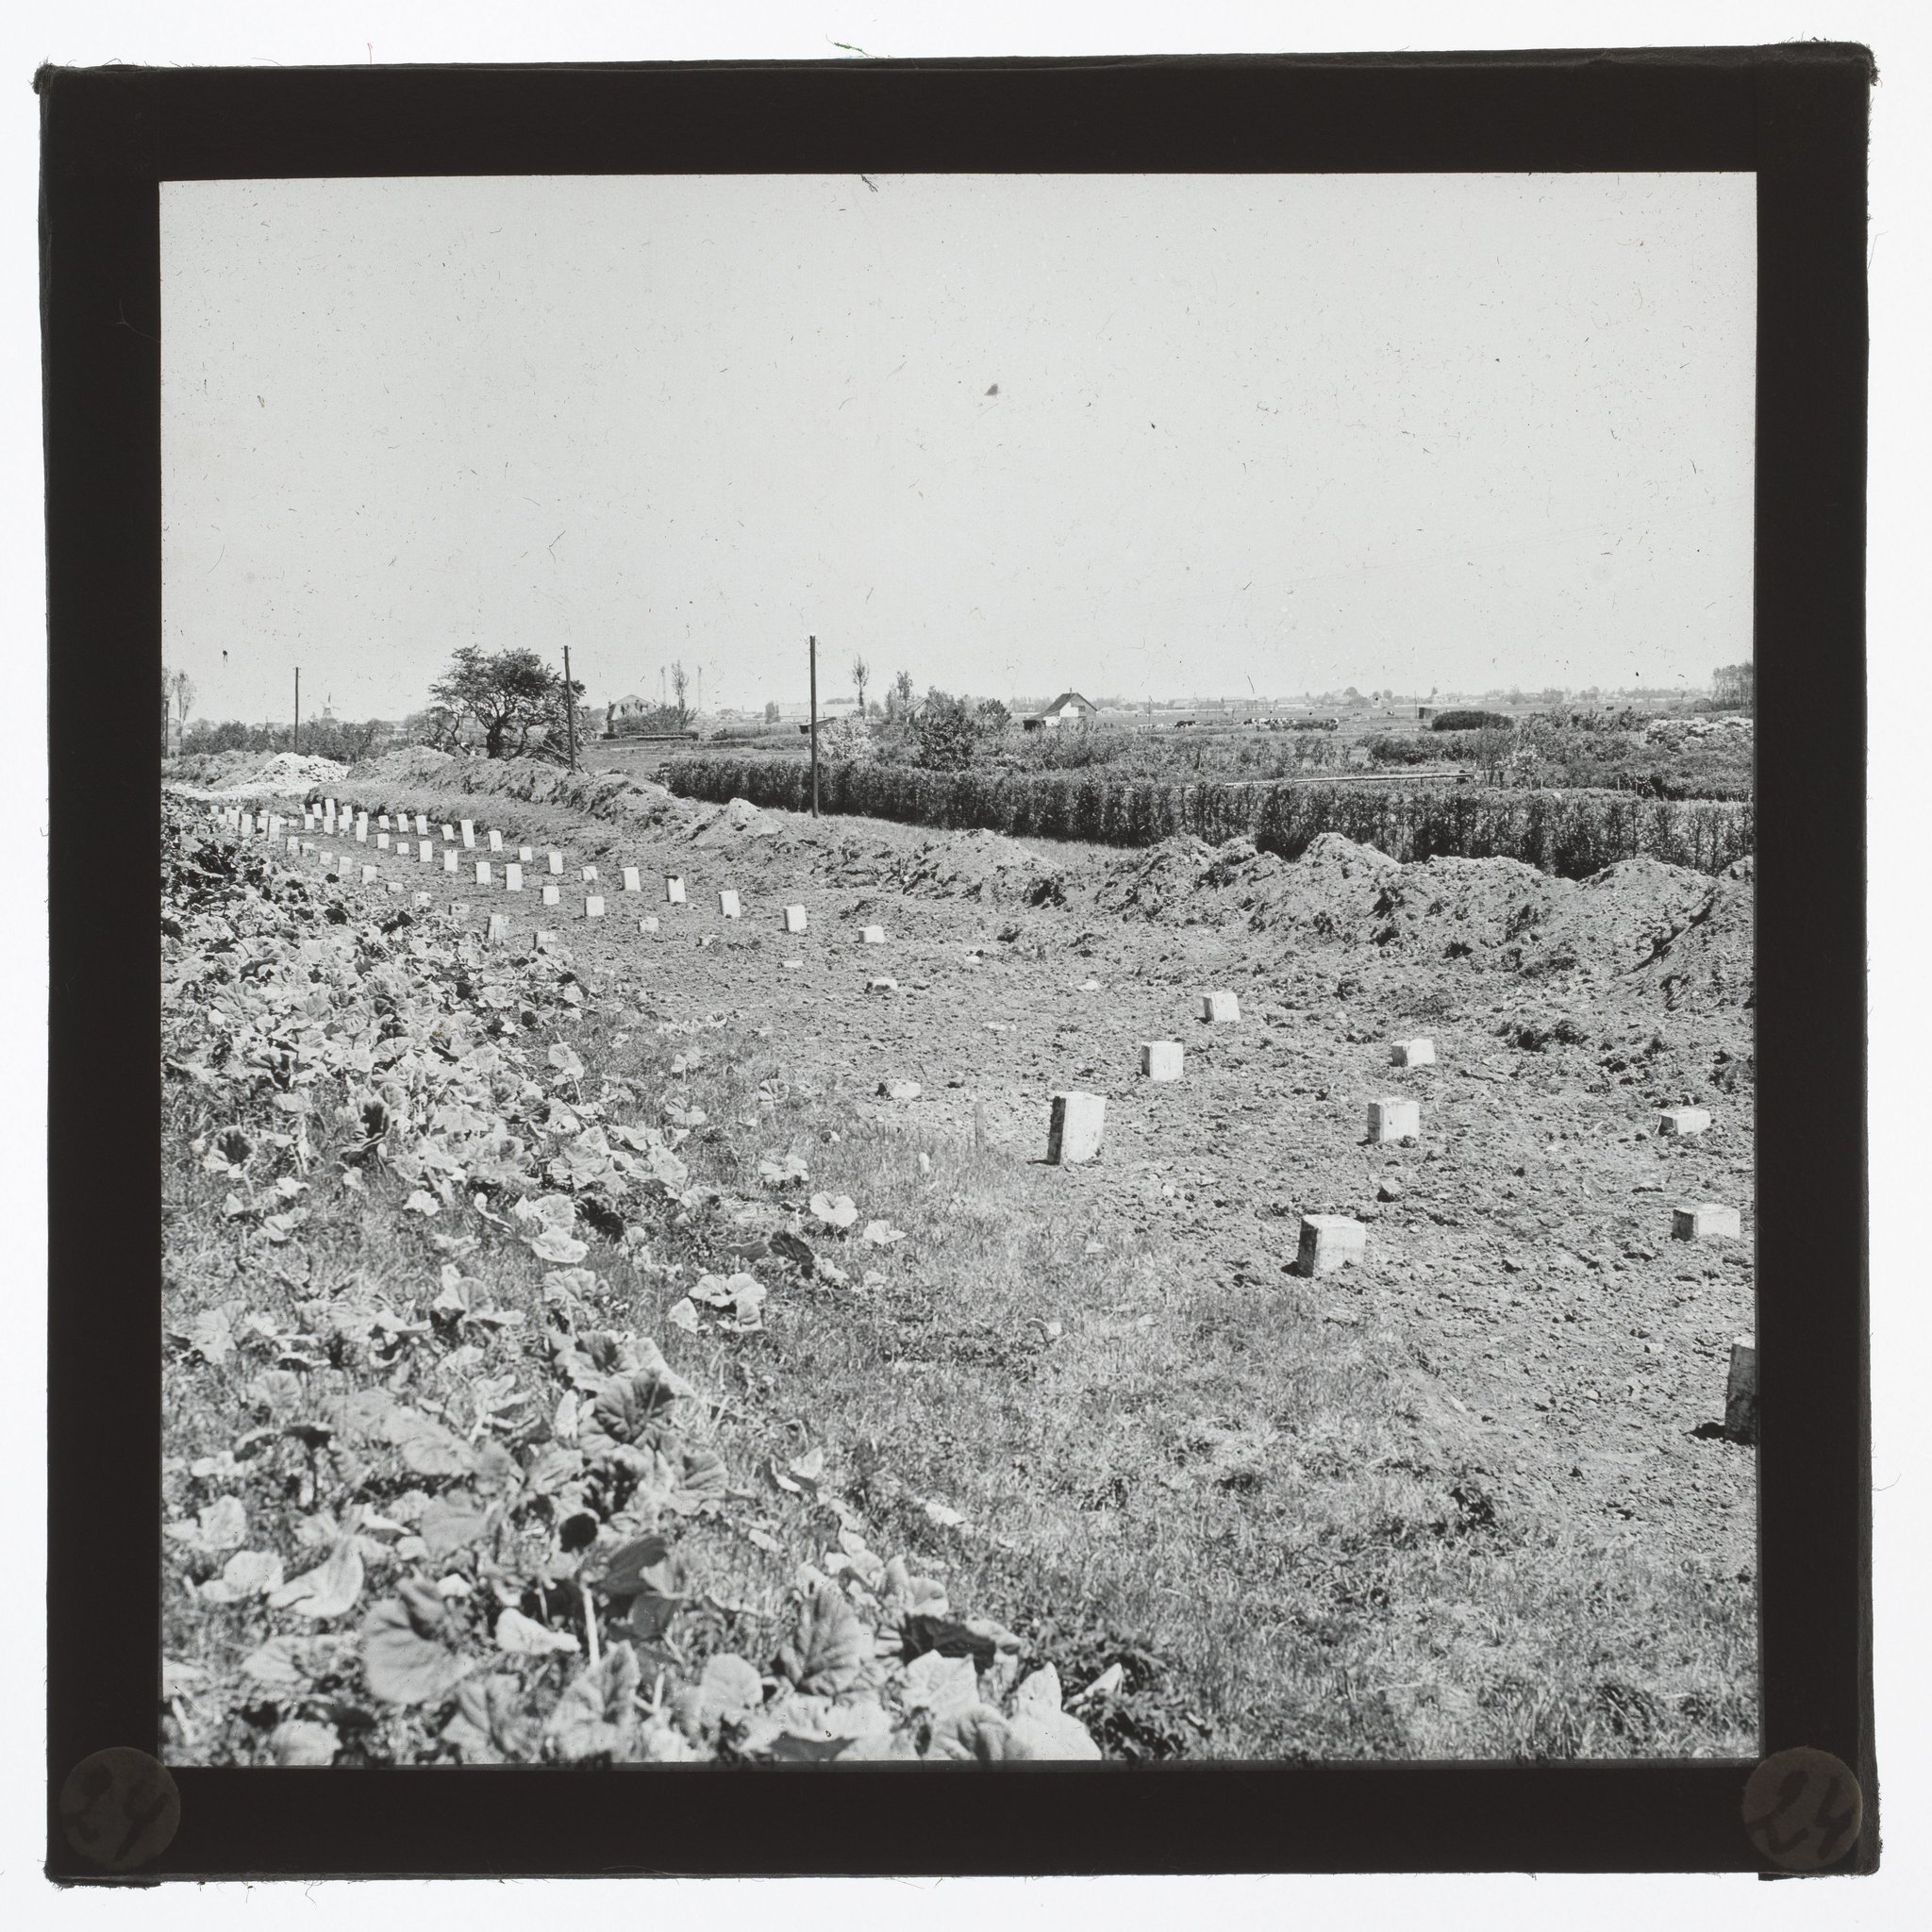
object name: lantern slide photographic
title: Bouwplaats met palen, Zuid-Holland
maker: Anonymous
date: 1956-1960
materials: glass, paper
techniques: gelatin silver transparency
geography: south holland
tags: building-site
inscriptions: number: ‘24’